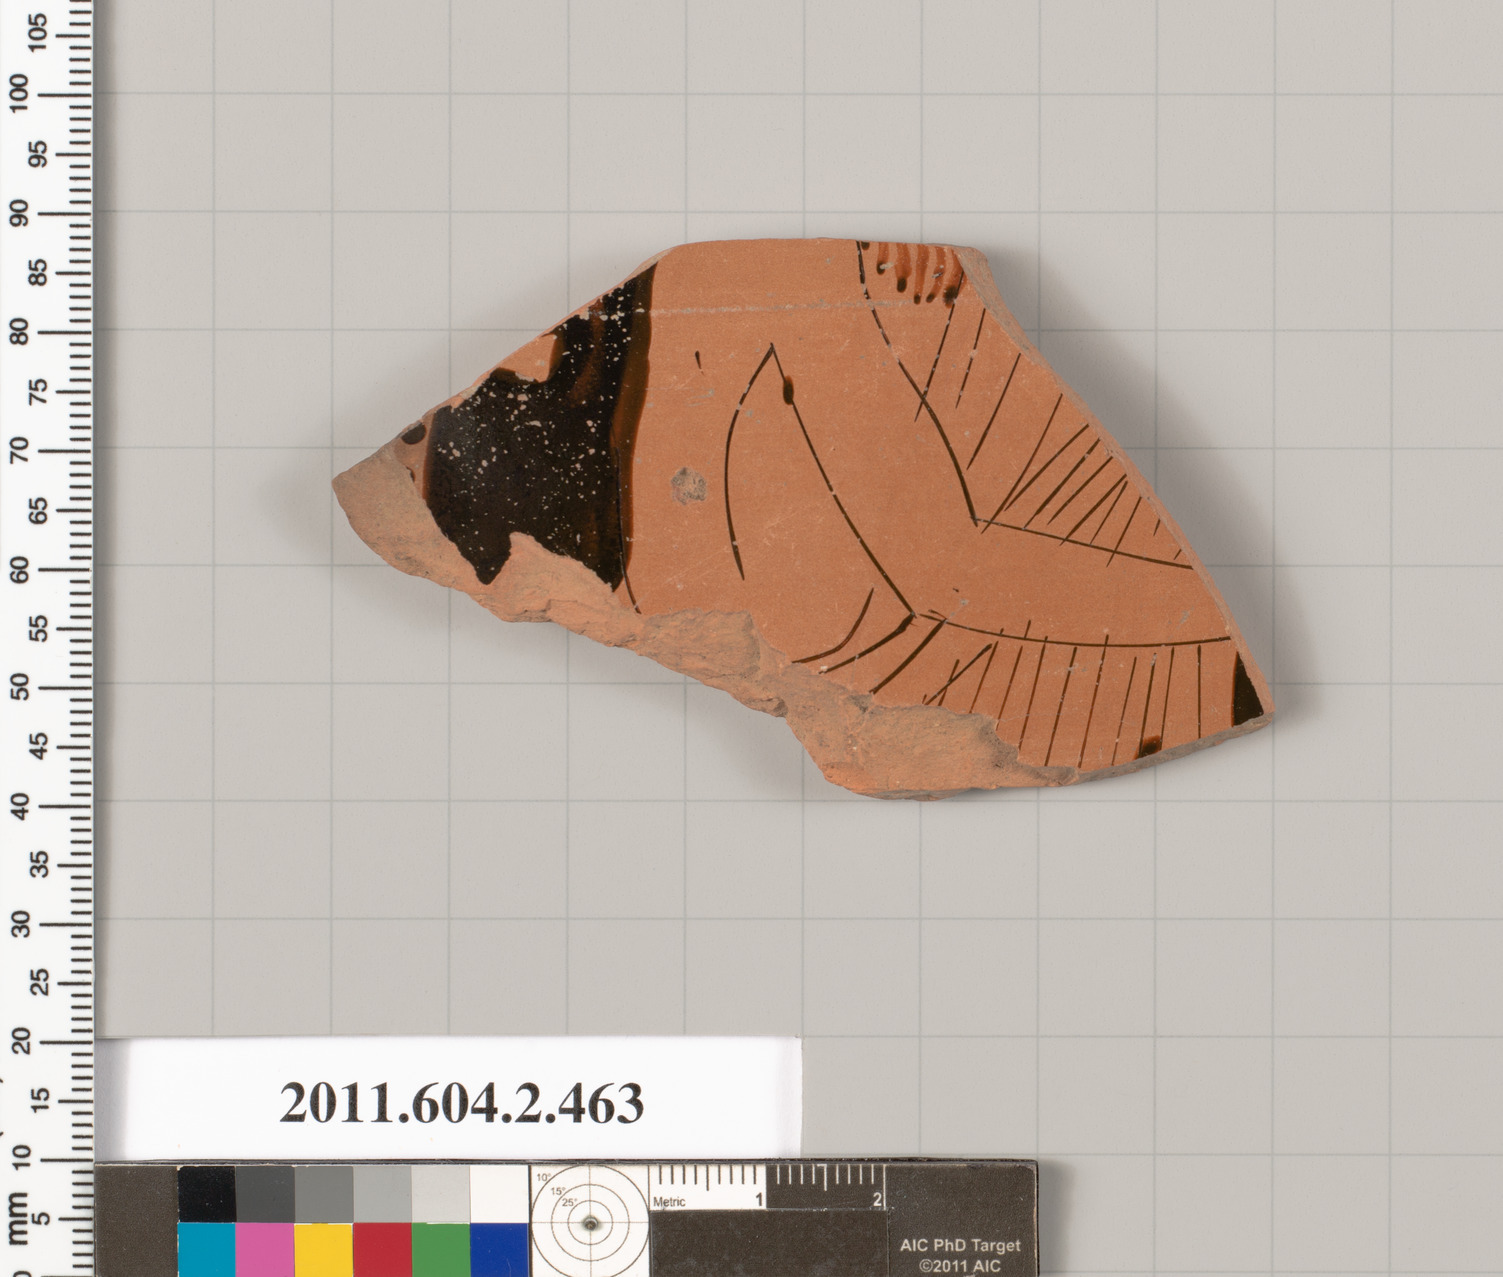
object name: column krater fragment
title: Terracotta fragment of a column-krater (bowl for mixing wine and water)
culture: greek, attic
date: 460-440 BCE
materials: terracotta